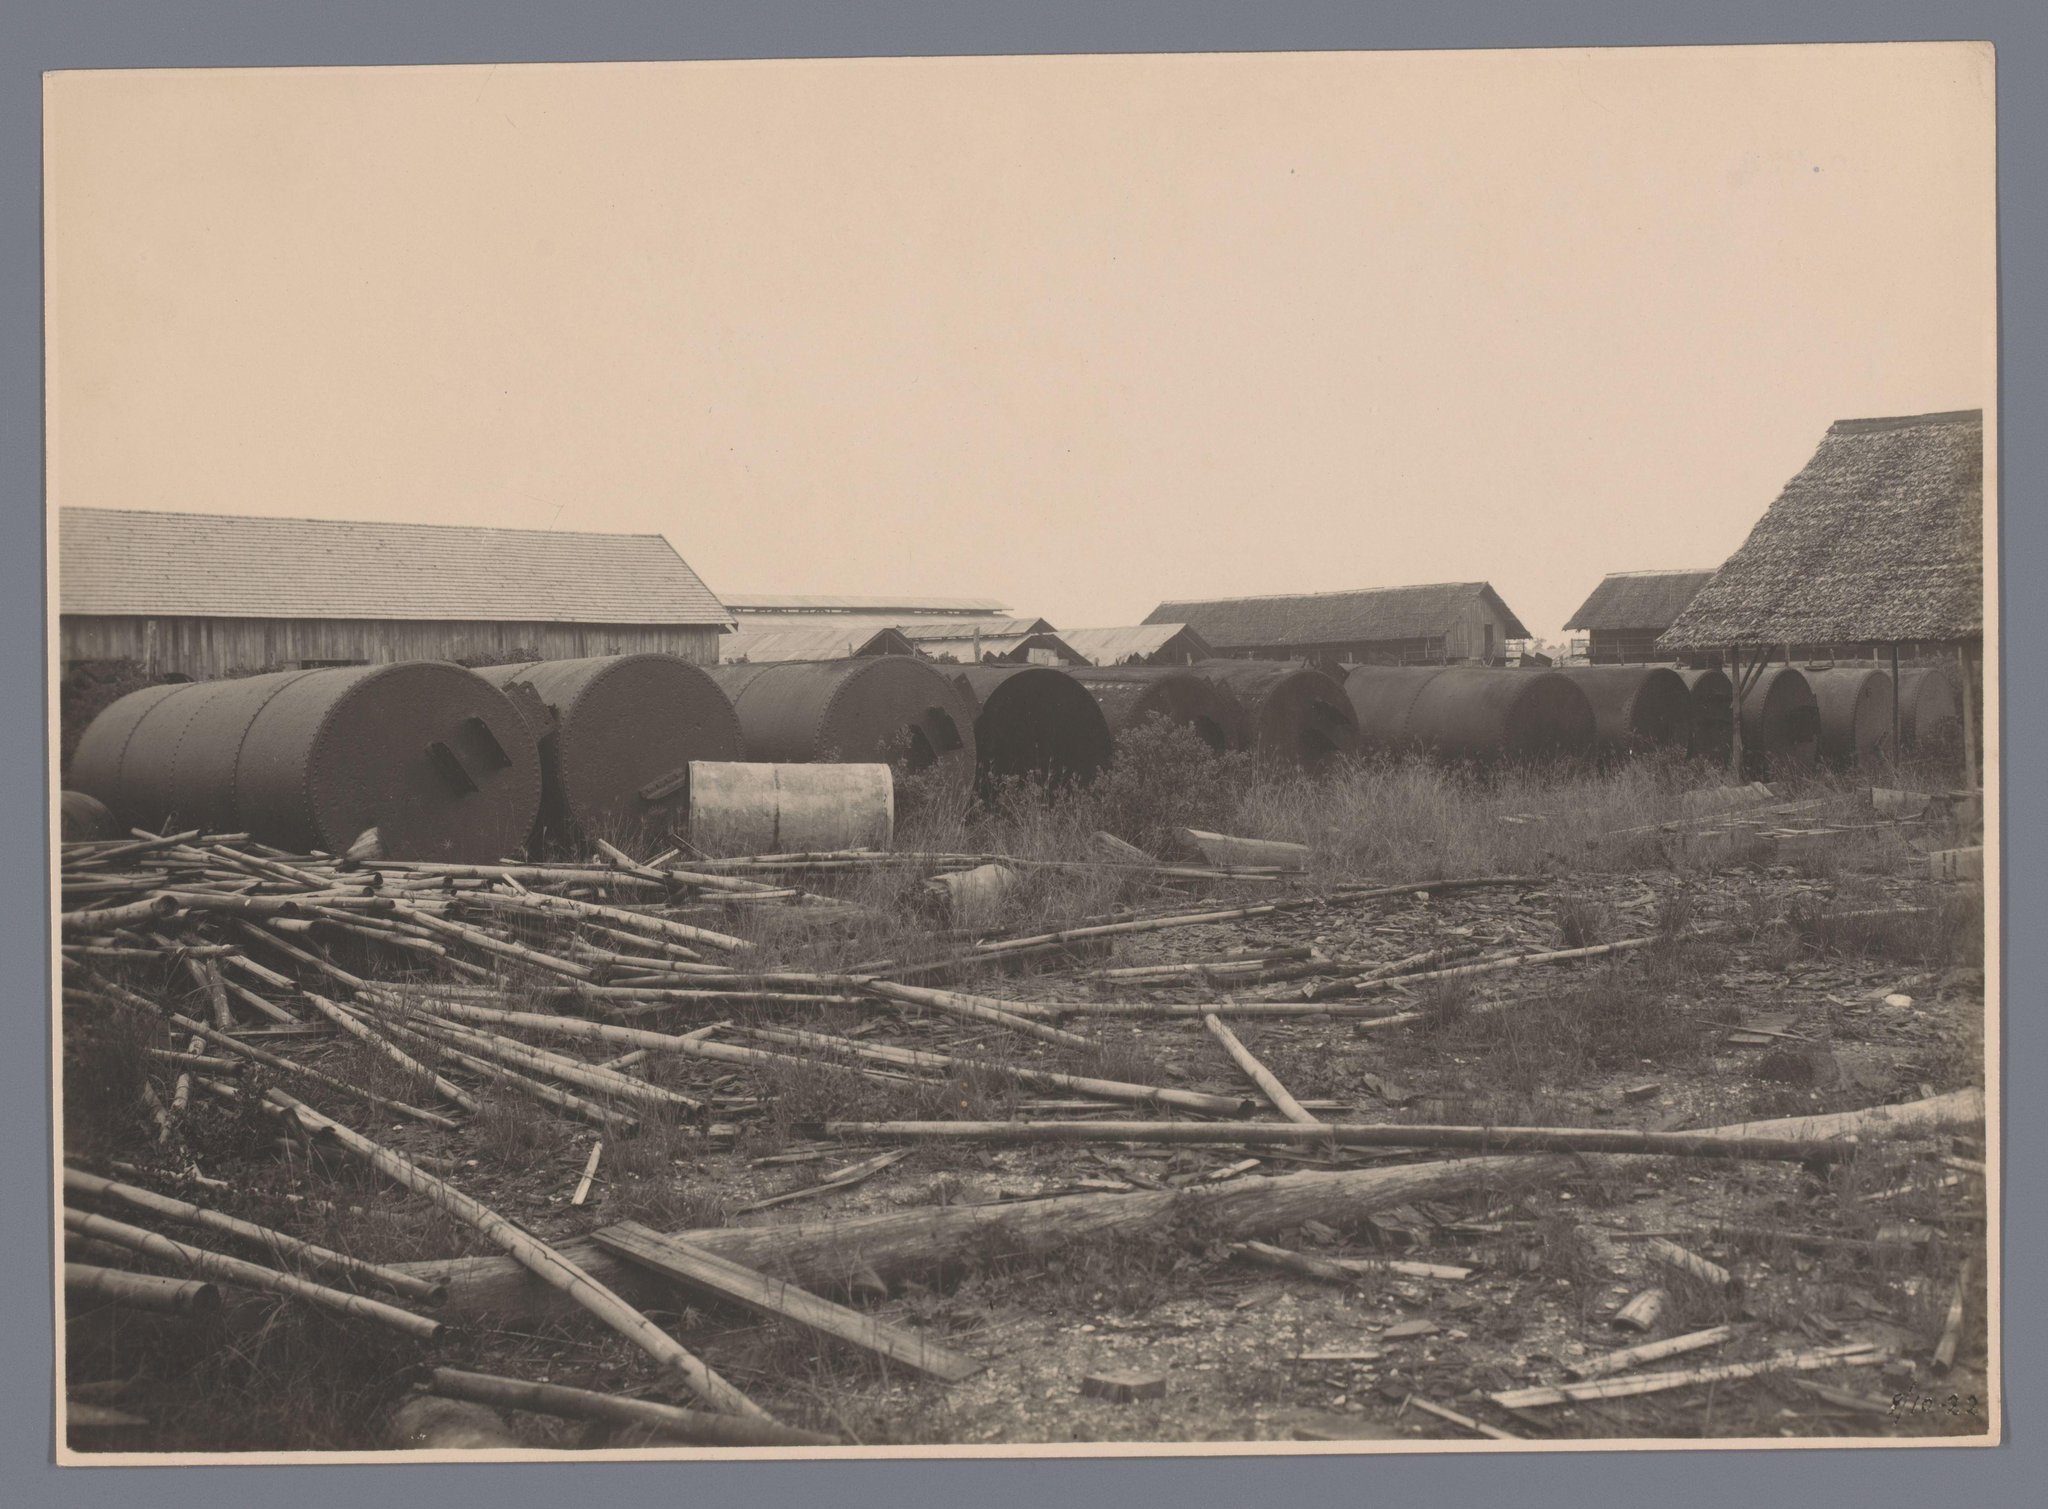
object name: photograph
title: Oceaanhaven Belawan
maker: Anonymous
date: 1922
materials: photographic support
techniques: gelatin silver print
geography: belawan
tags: harbour equipment, building-site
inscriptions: annotation: ‘No. 238 Pontons’, date: ‘8/10-22’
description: Werkterrein waar een aantal pontons liggen. Genummerd: 238. Onderdeel van de groep van losse foto's over de aanleg van de haven Belawan aan de kust voor Medan, Sumatra 1921-1922.